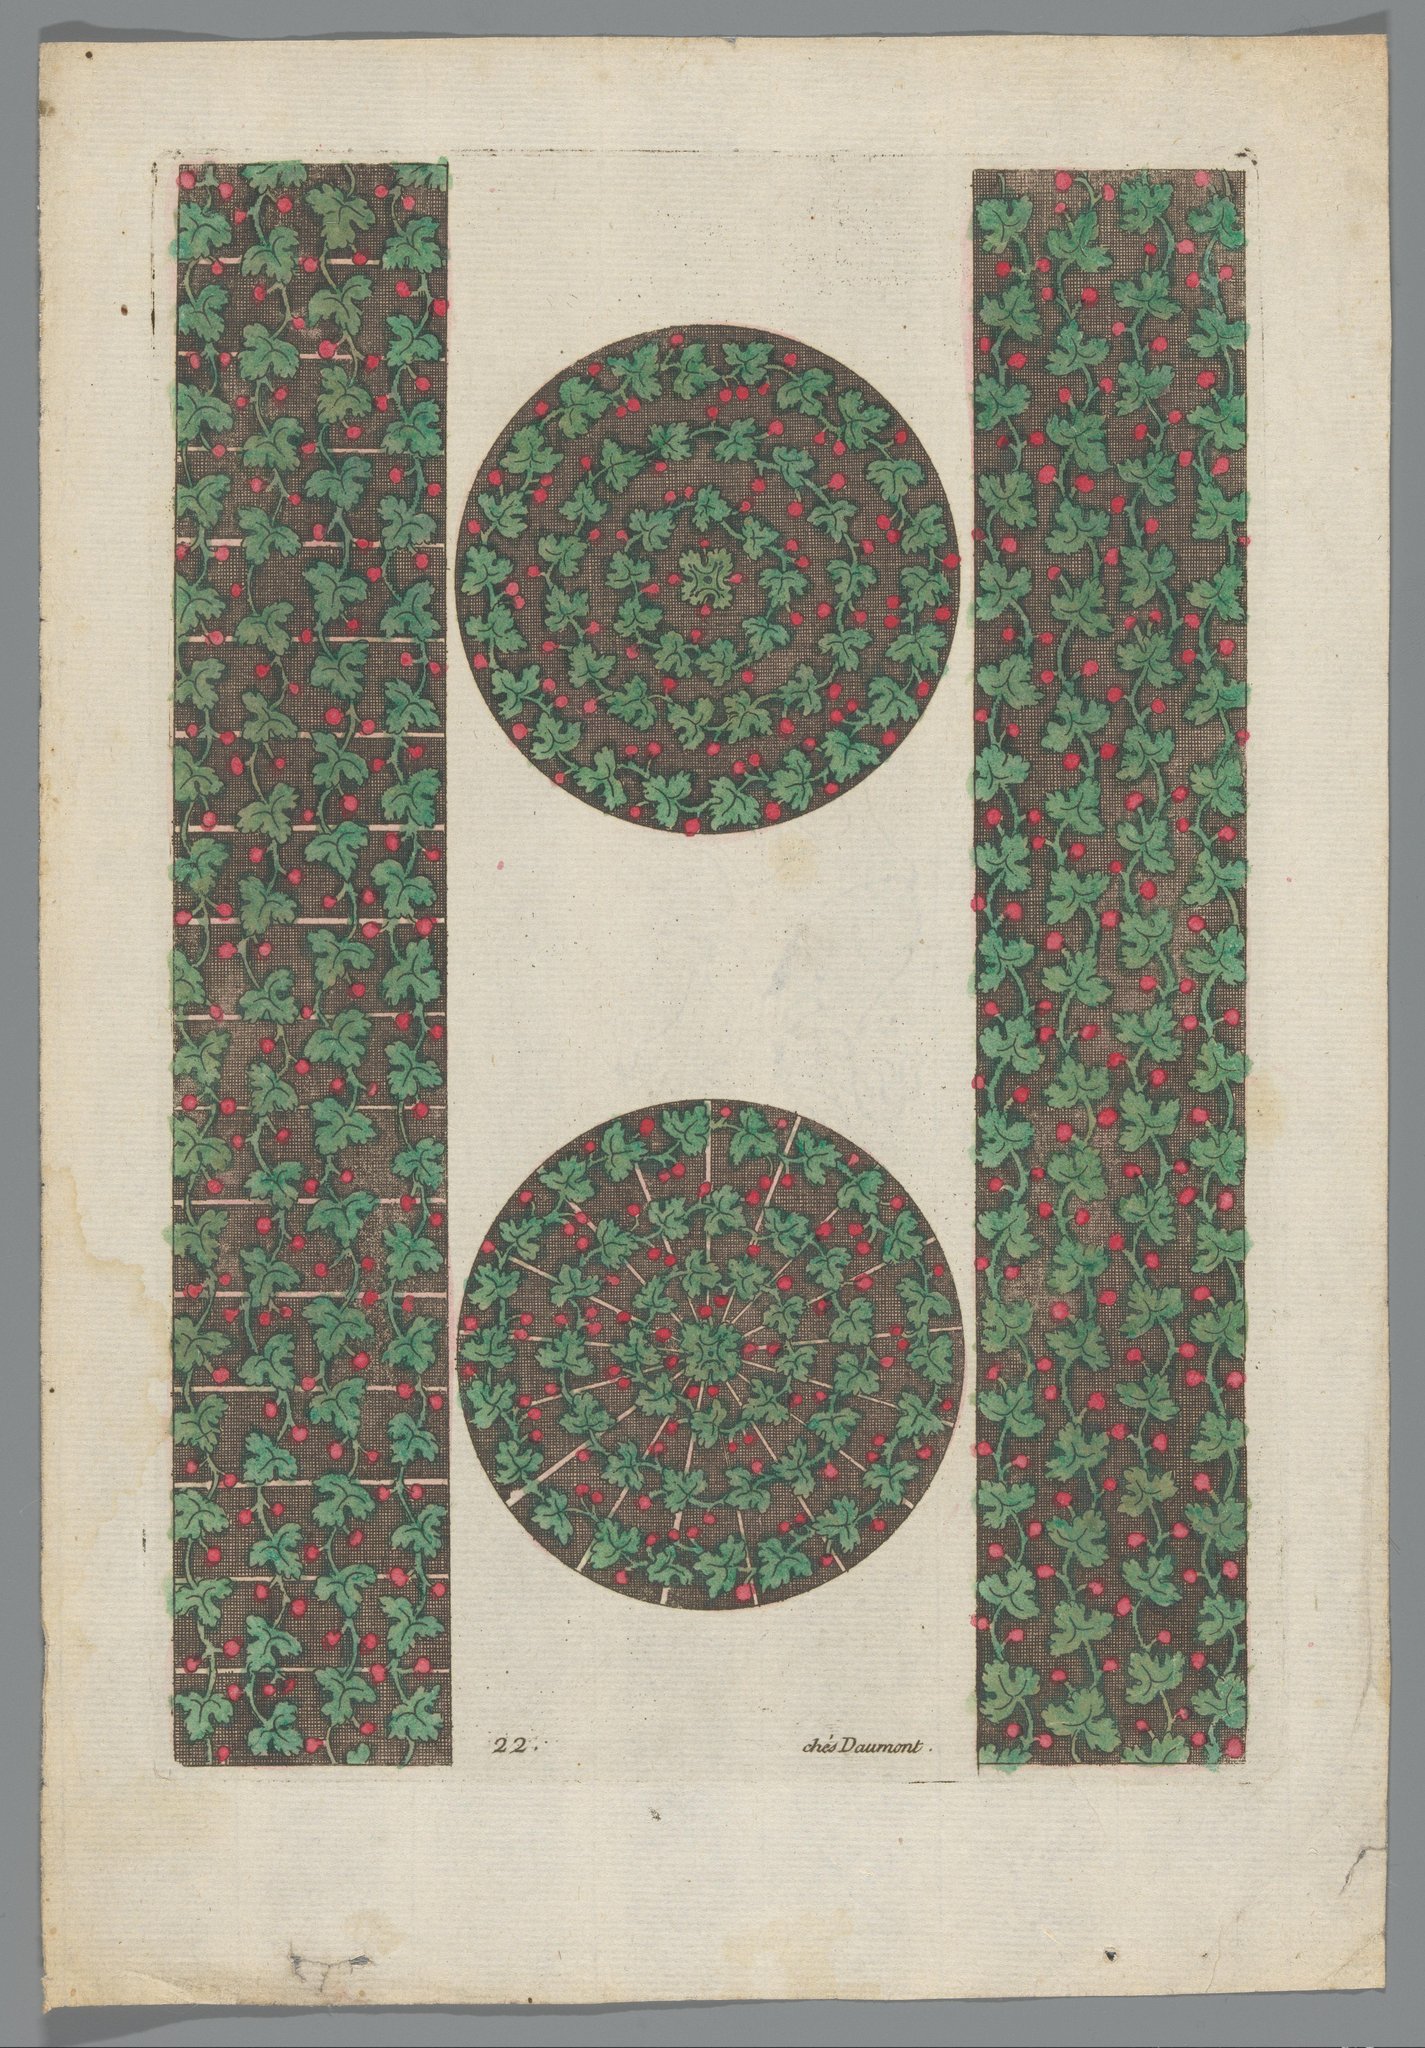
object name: print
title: Bladen met knipplaatjes en decoratieve randen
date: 1750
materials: paper, watercolor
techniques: etching, hand coloring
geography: paris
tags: foliage, tendrils, branches ~ ornament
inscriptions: collector's mark: Lugt 2228, collector's mark: Lugt 2760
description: Twee ronde en twee rechthoekige vormen versierd met bladeren en bessen. Linksonder genummerd: 22. Een van 39 bladen met knipplaatjes en decoratieve randen.